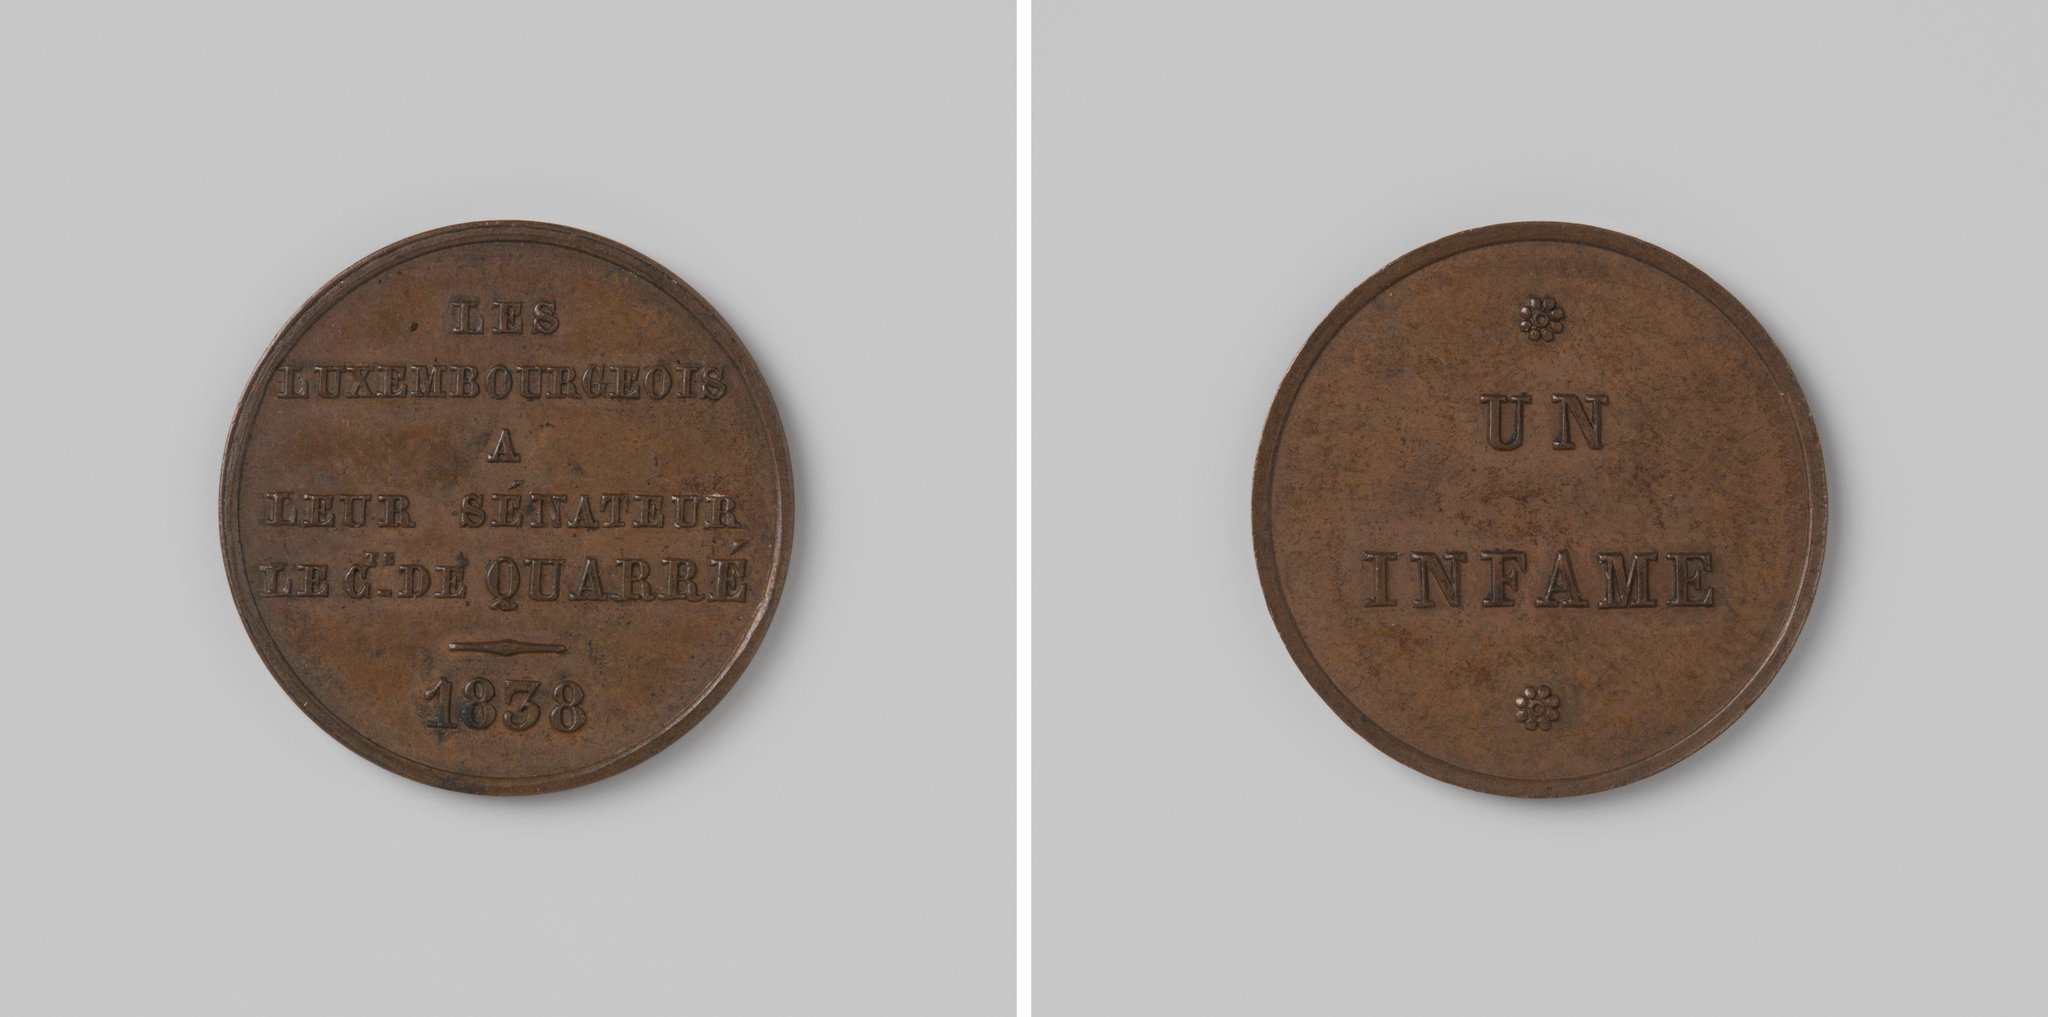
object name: history medal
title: Protest tegen de instemming van graaf de Quarre met het besluit om Luxemburg en Limburg te verdelen tussen België en Nederland, penning geslagen door de inwoners van Arlon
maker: Anonymous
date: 1838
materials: bronze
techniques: striking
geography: arlon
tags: graaf de quarre, arlon, luxemburg (land), luxemburg (belgische provincie), limburg (belgische provincie), limburg (nederlandse provincie), limburgs-luxemburgse kwestie, belgische revolutie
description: Bronzen penning. Voorzijde: opschrift. Keerzijde: opschrift tussen twee rozen.